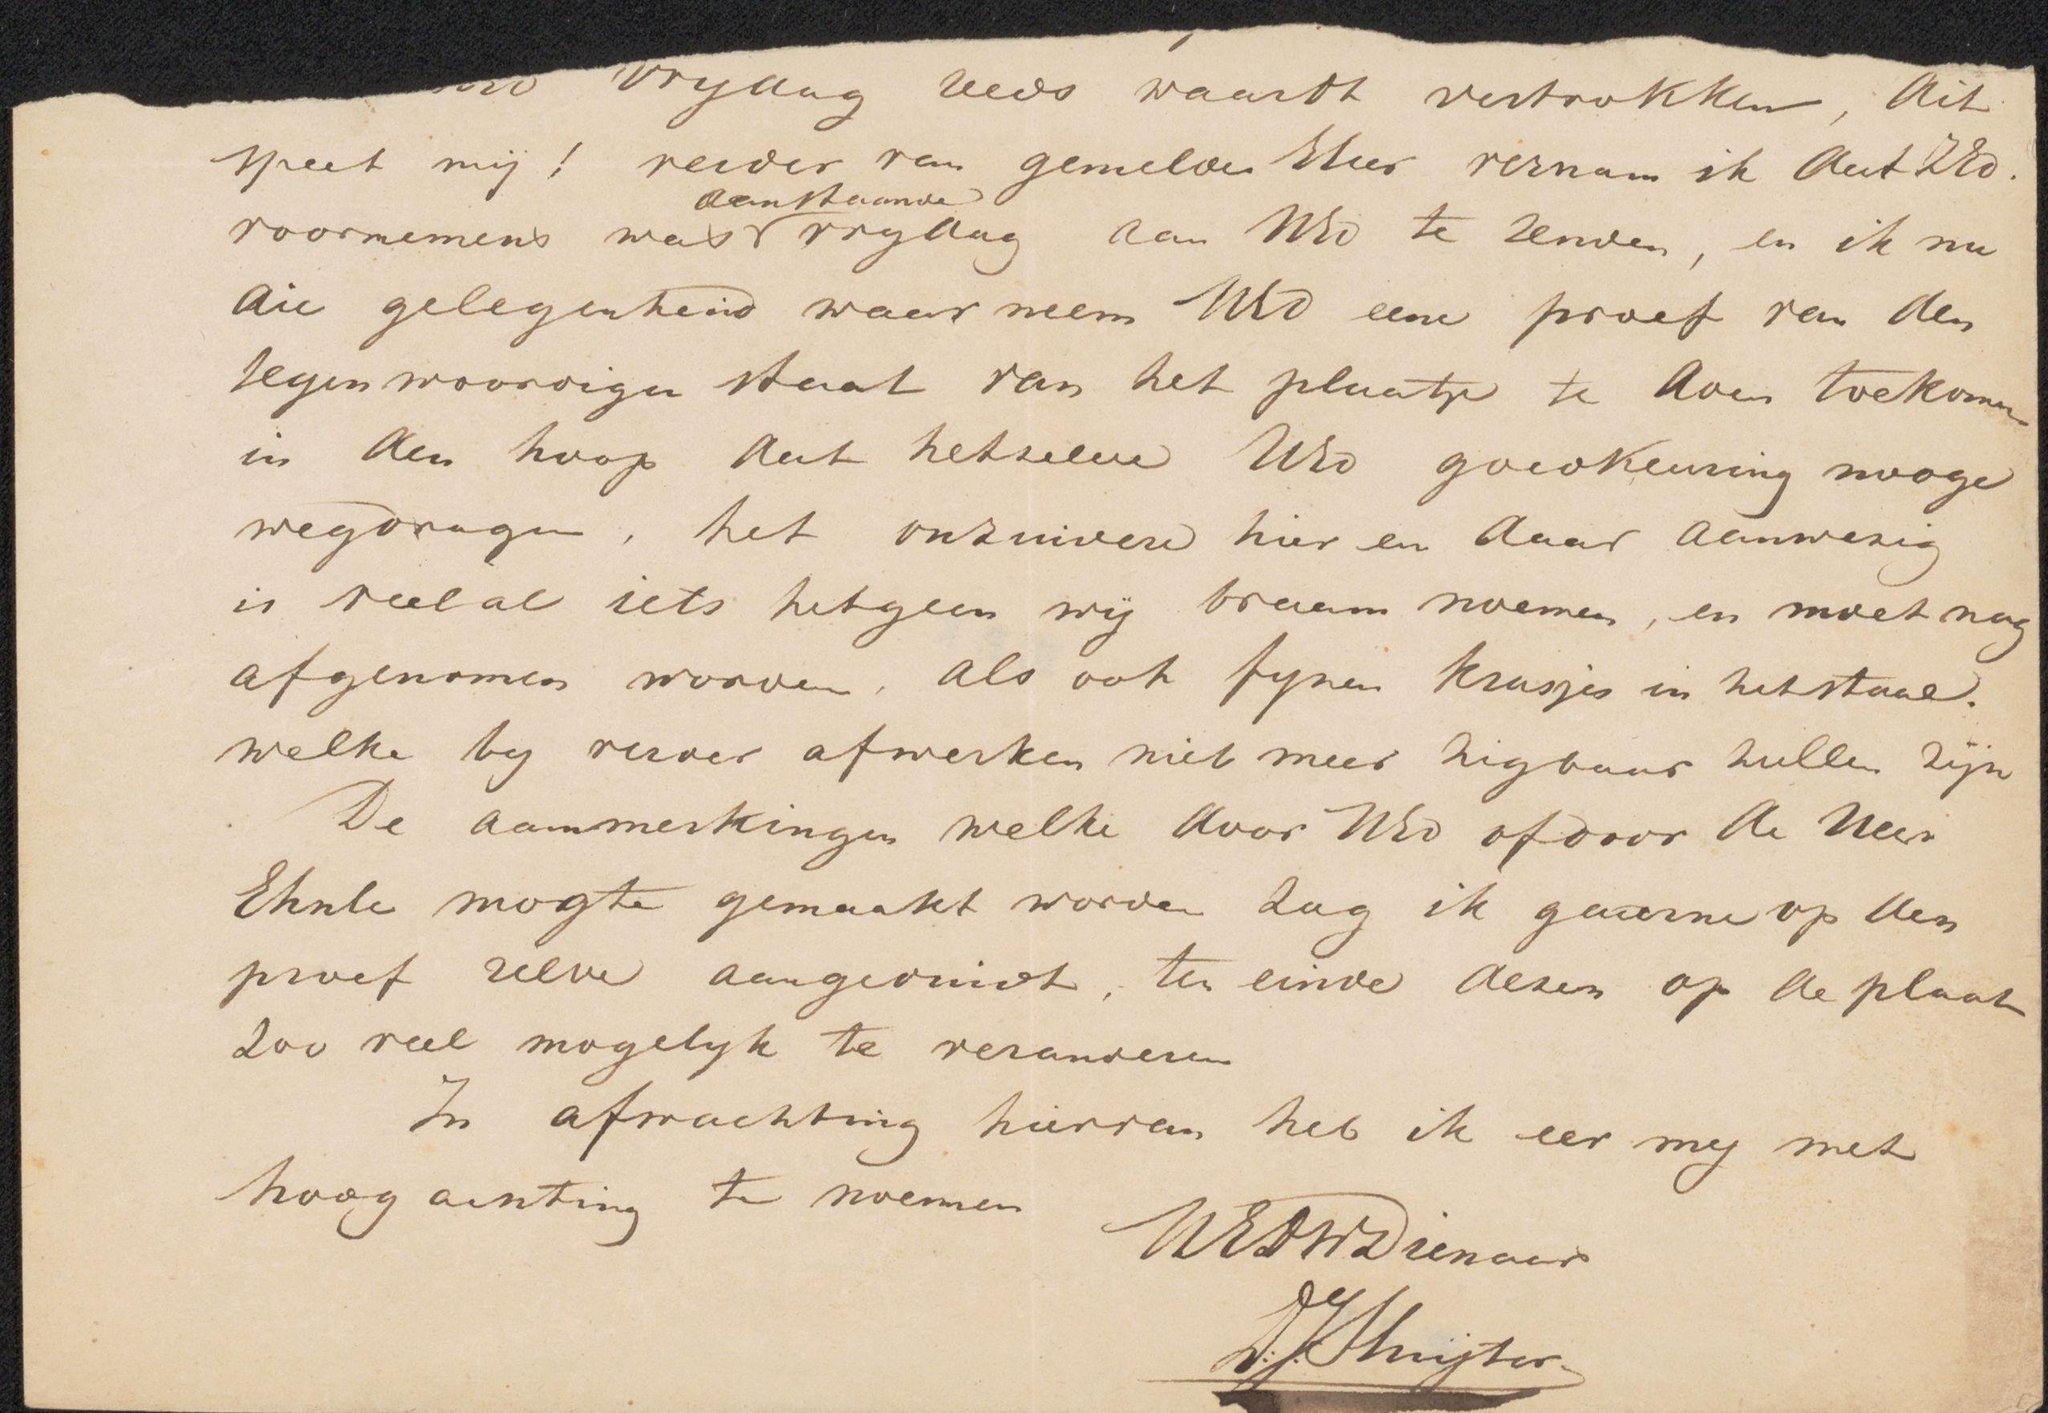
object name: letter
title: Brief aan anoniem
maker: dirk jurriaan sluyter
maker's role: draughtsman, print maker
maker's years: 1811-1886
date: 1821-1886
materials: ink, paper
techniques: pen, writing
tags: the graphic arts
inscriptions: collector's mark: Lugt 2233